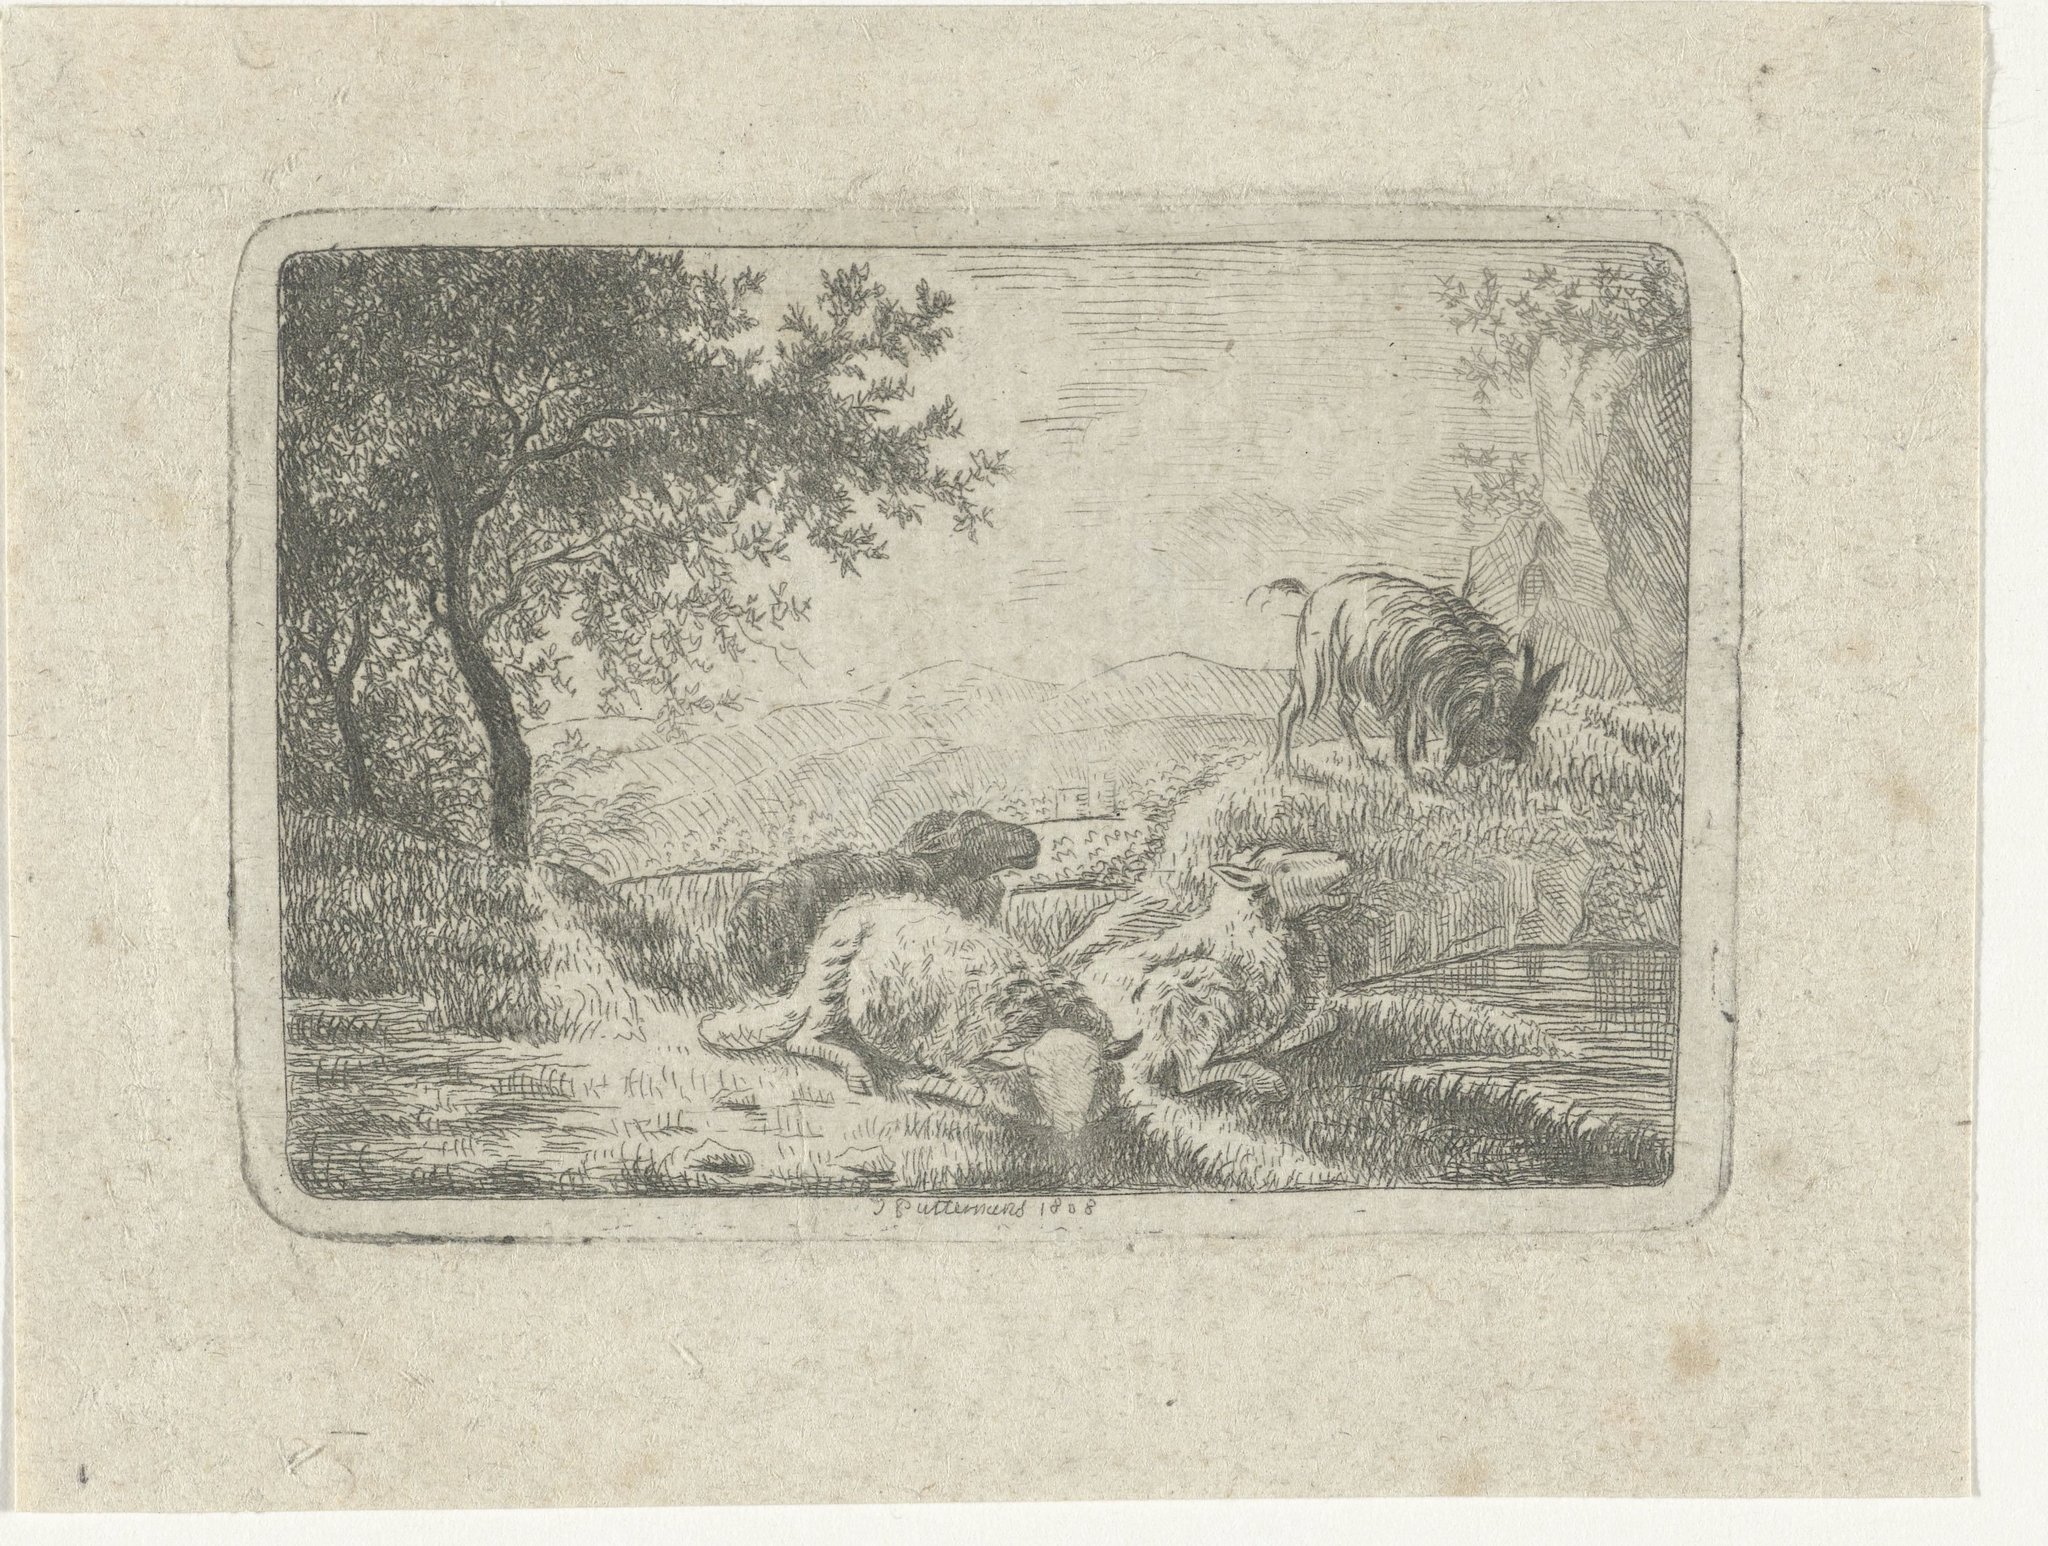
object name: print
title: Landschap met schapen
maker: j. puttemans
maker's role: print maker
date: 1808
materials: paper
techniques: etching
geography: netherlands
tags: landscapes, sheep, pond, pool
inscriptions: collector's mark: Lugt 2228